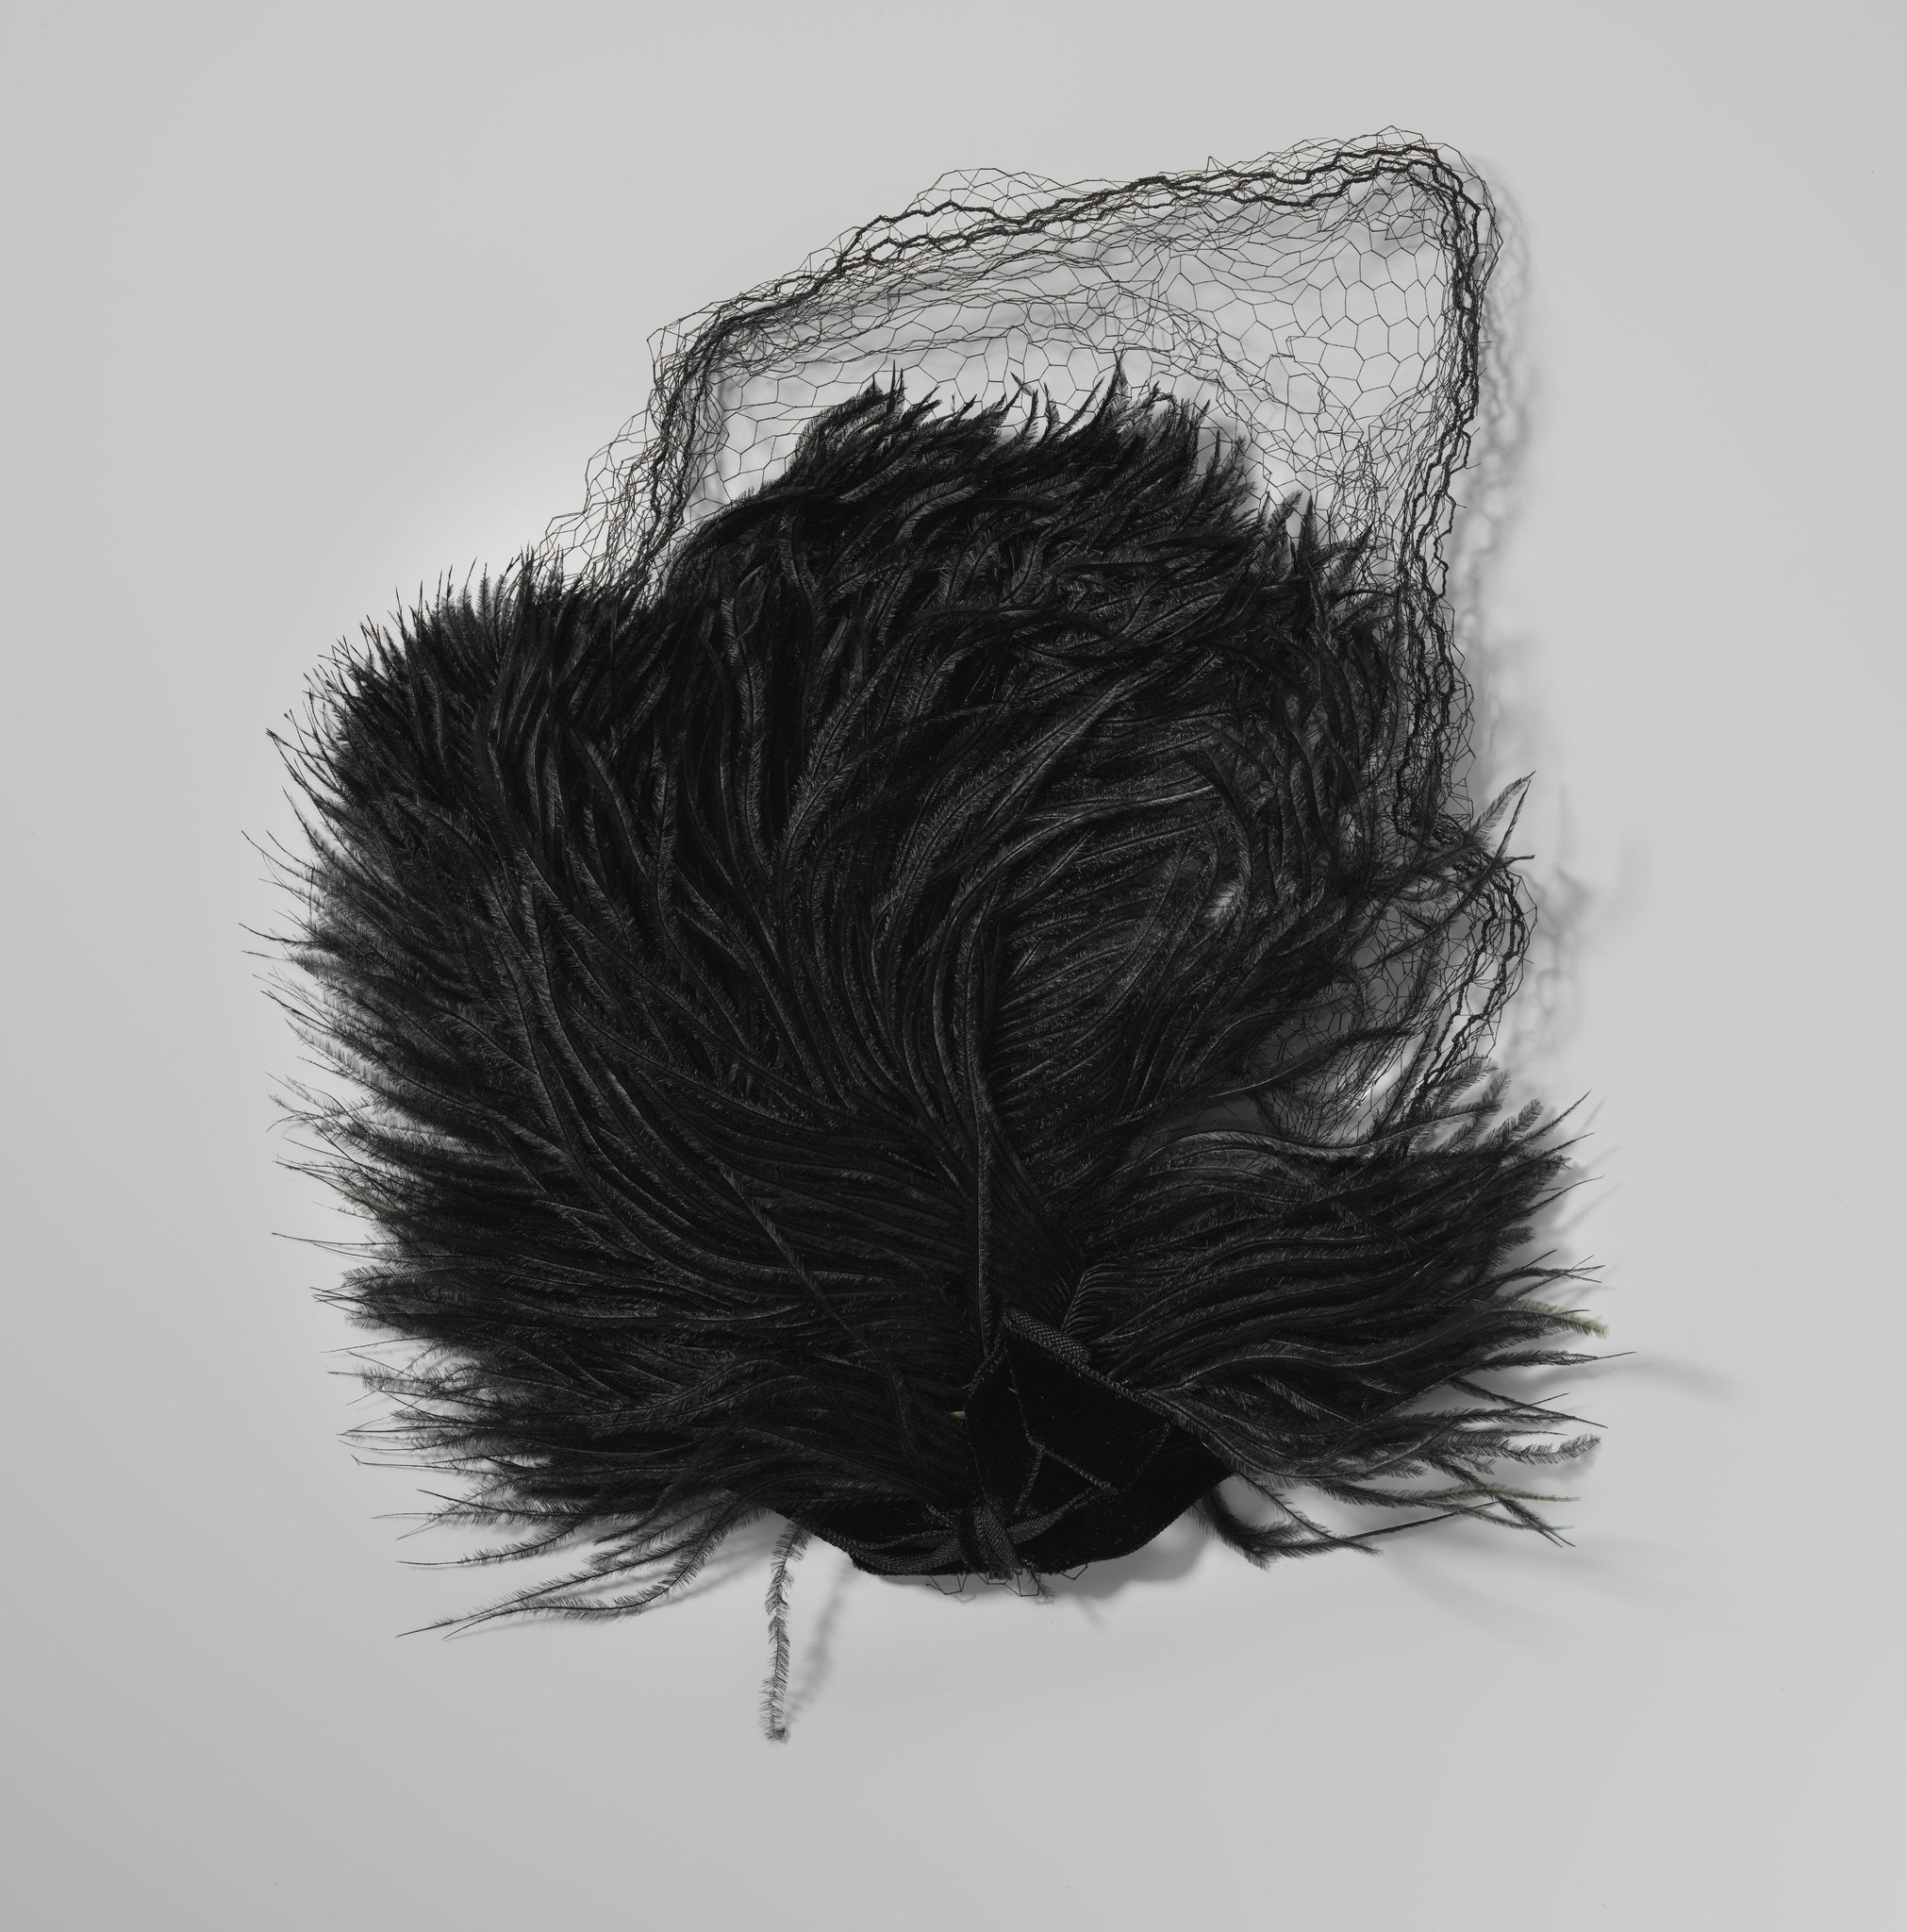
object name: hoedenveer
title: Toef struisveren met voile en fluwelen strik, geheel zwart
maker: Anonymous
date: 1880-1925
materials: velvet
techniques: painting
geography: western europe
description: Toef struisveren met voile en fluwelen strik, geheel zwart.